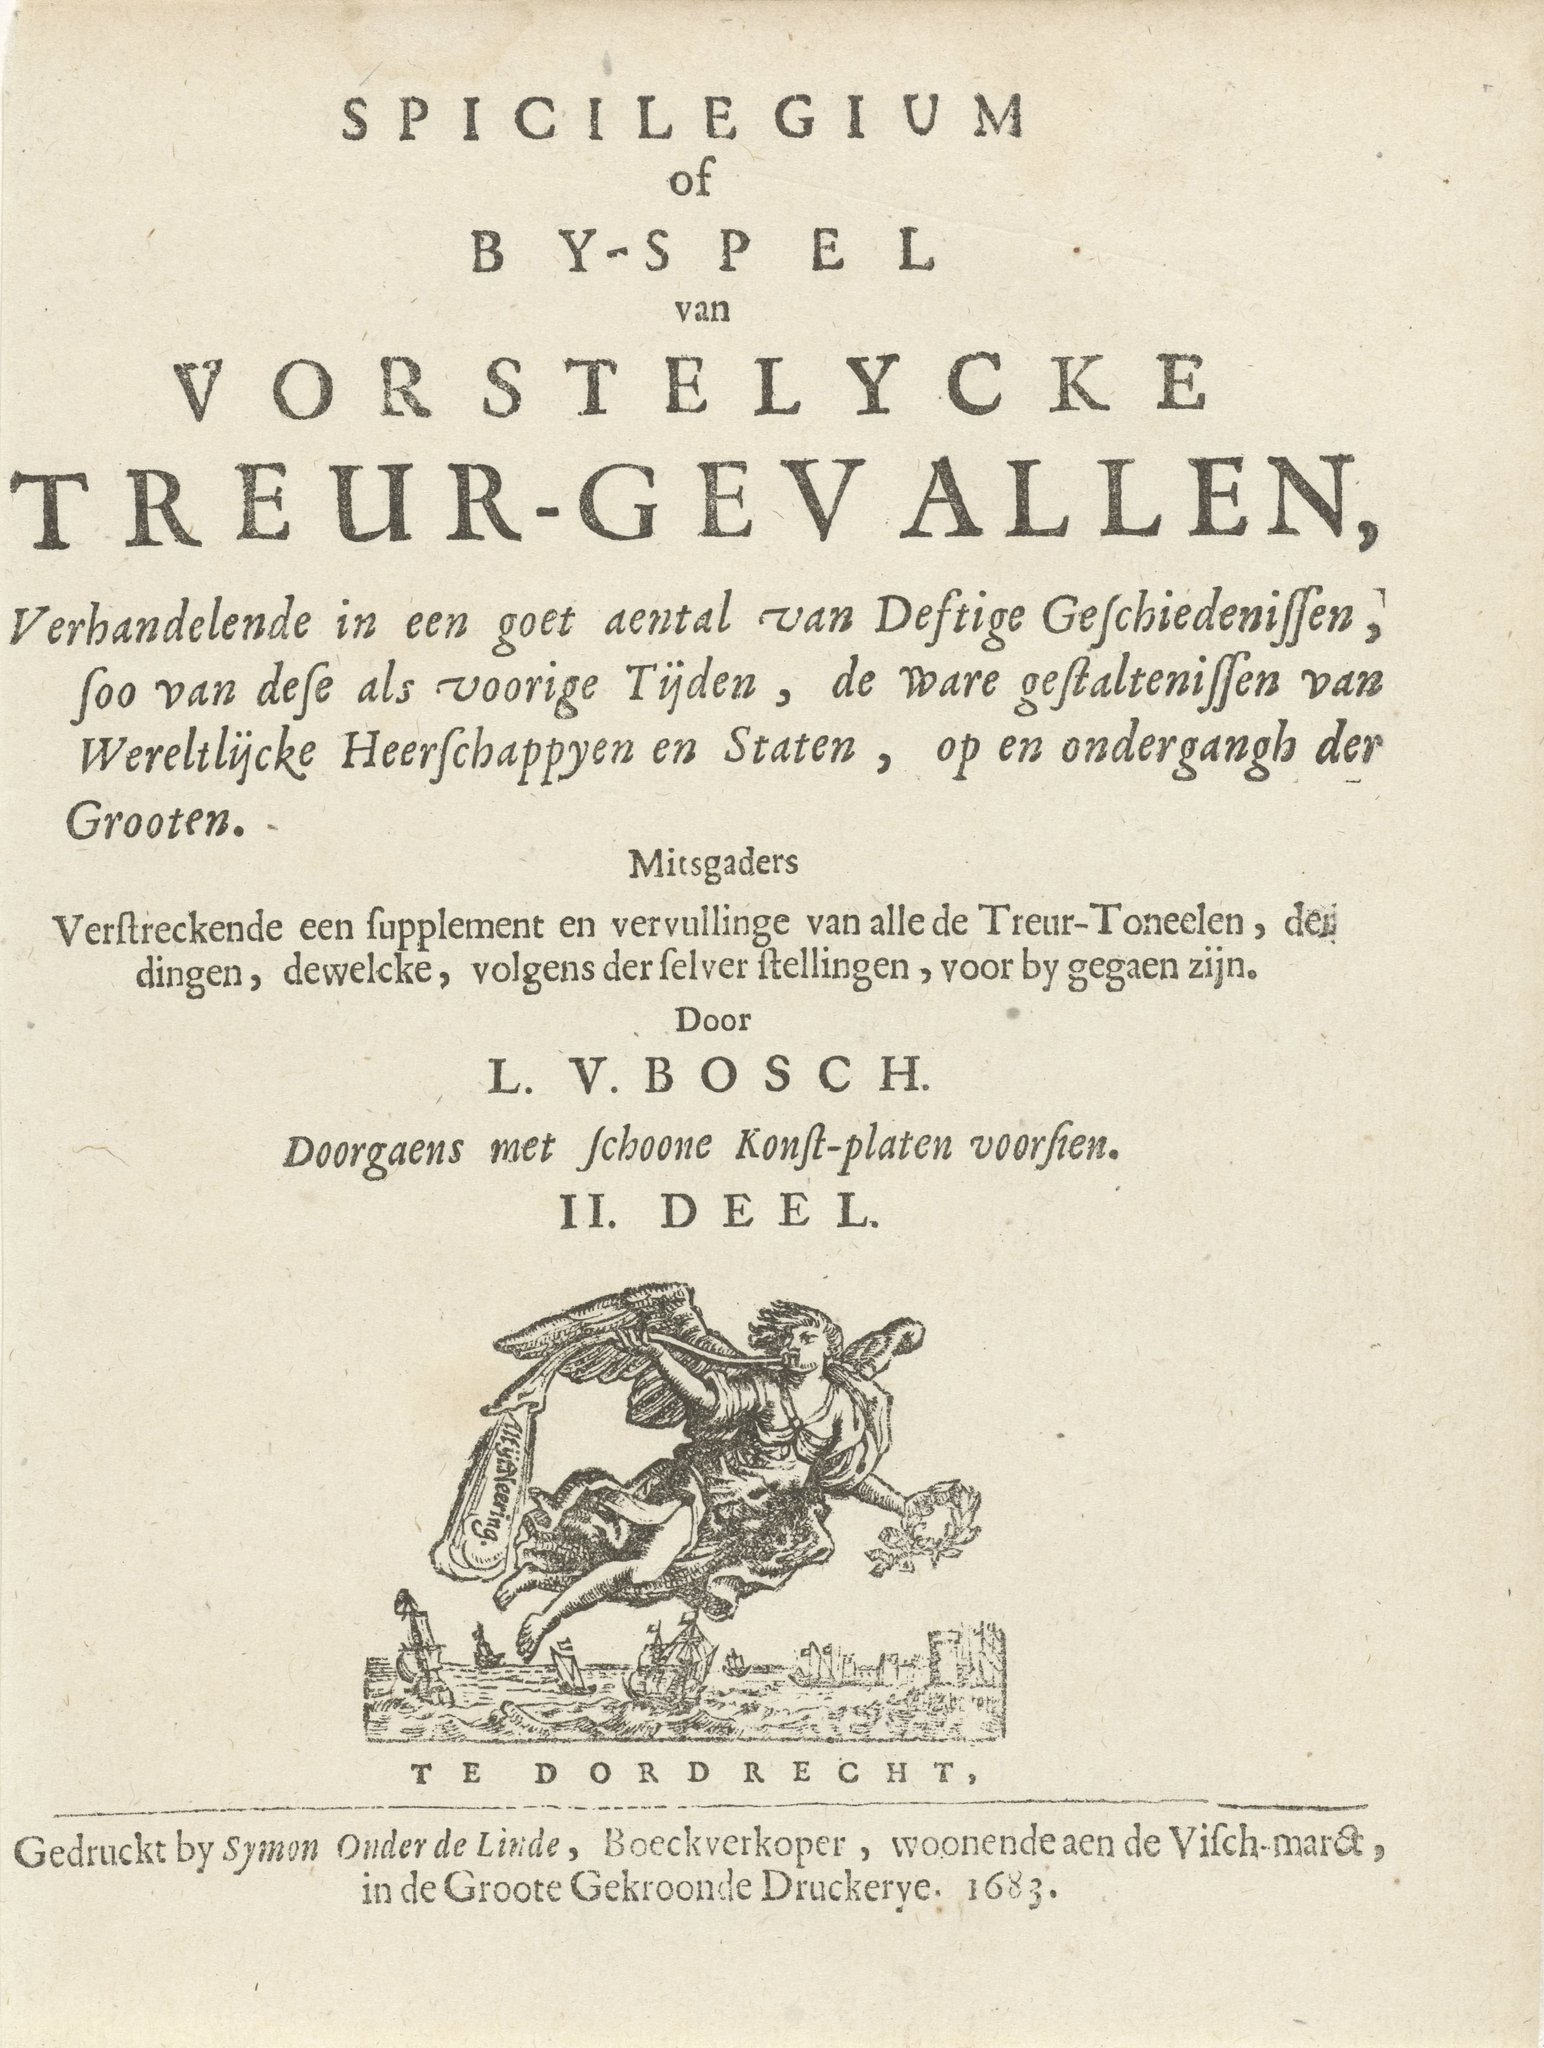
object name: print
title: Titelpagina voor: L. van den Bos, Spicilegium of by-spel van vorstelycke treur-gevallen; deel 2 van: Het toneel der ongevallen, 1683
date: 1683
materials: paper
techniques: etching, letterpress printing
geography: dordrecht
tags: fame; 'fama', 'fama buona', 'fama chiara' (ripa)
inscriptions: collector's mark: Lugt 2228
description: Faam, met een lauwerkrans en een trompet, boven schepen op het water. Uit haar trompet komt de tekst: Altijtneering. Daarboven 17 regels in het Nederlands. Onderaan het impressum. Titelpagina voor deel 2 van (de eerste uitgave van) een boek van Lambert van den Bos met in totaal twinting prenten van Arnold Houbraken.